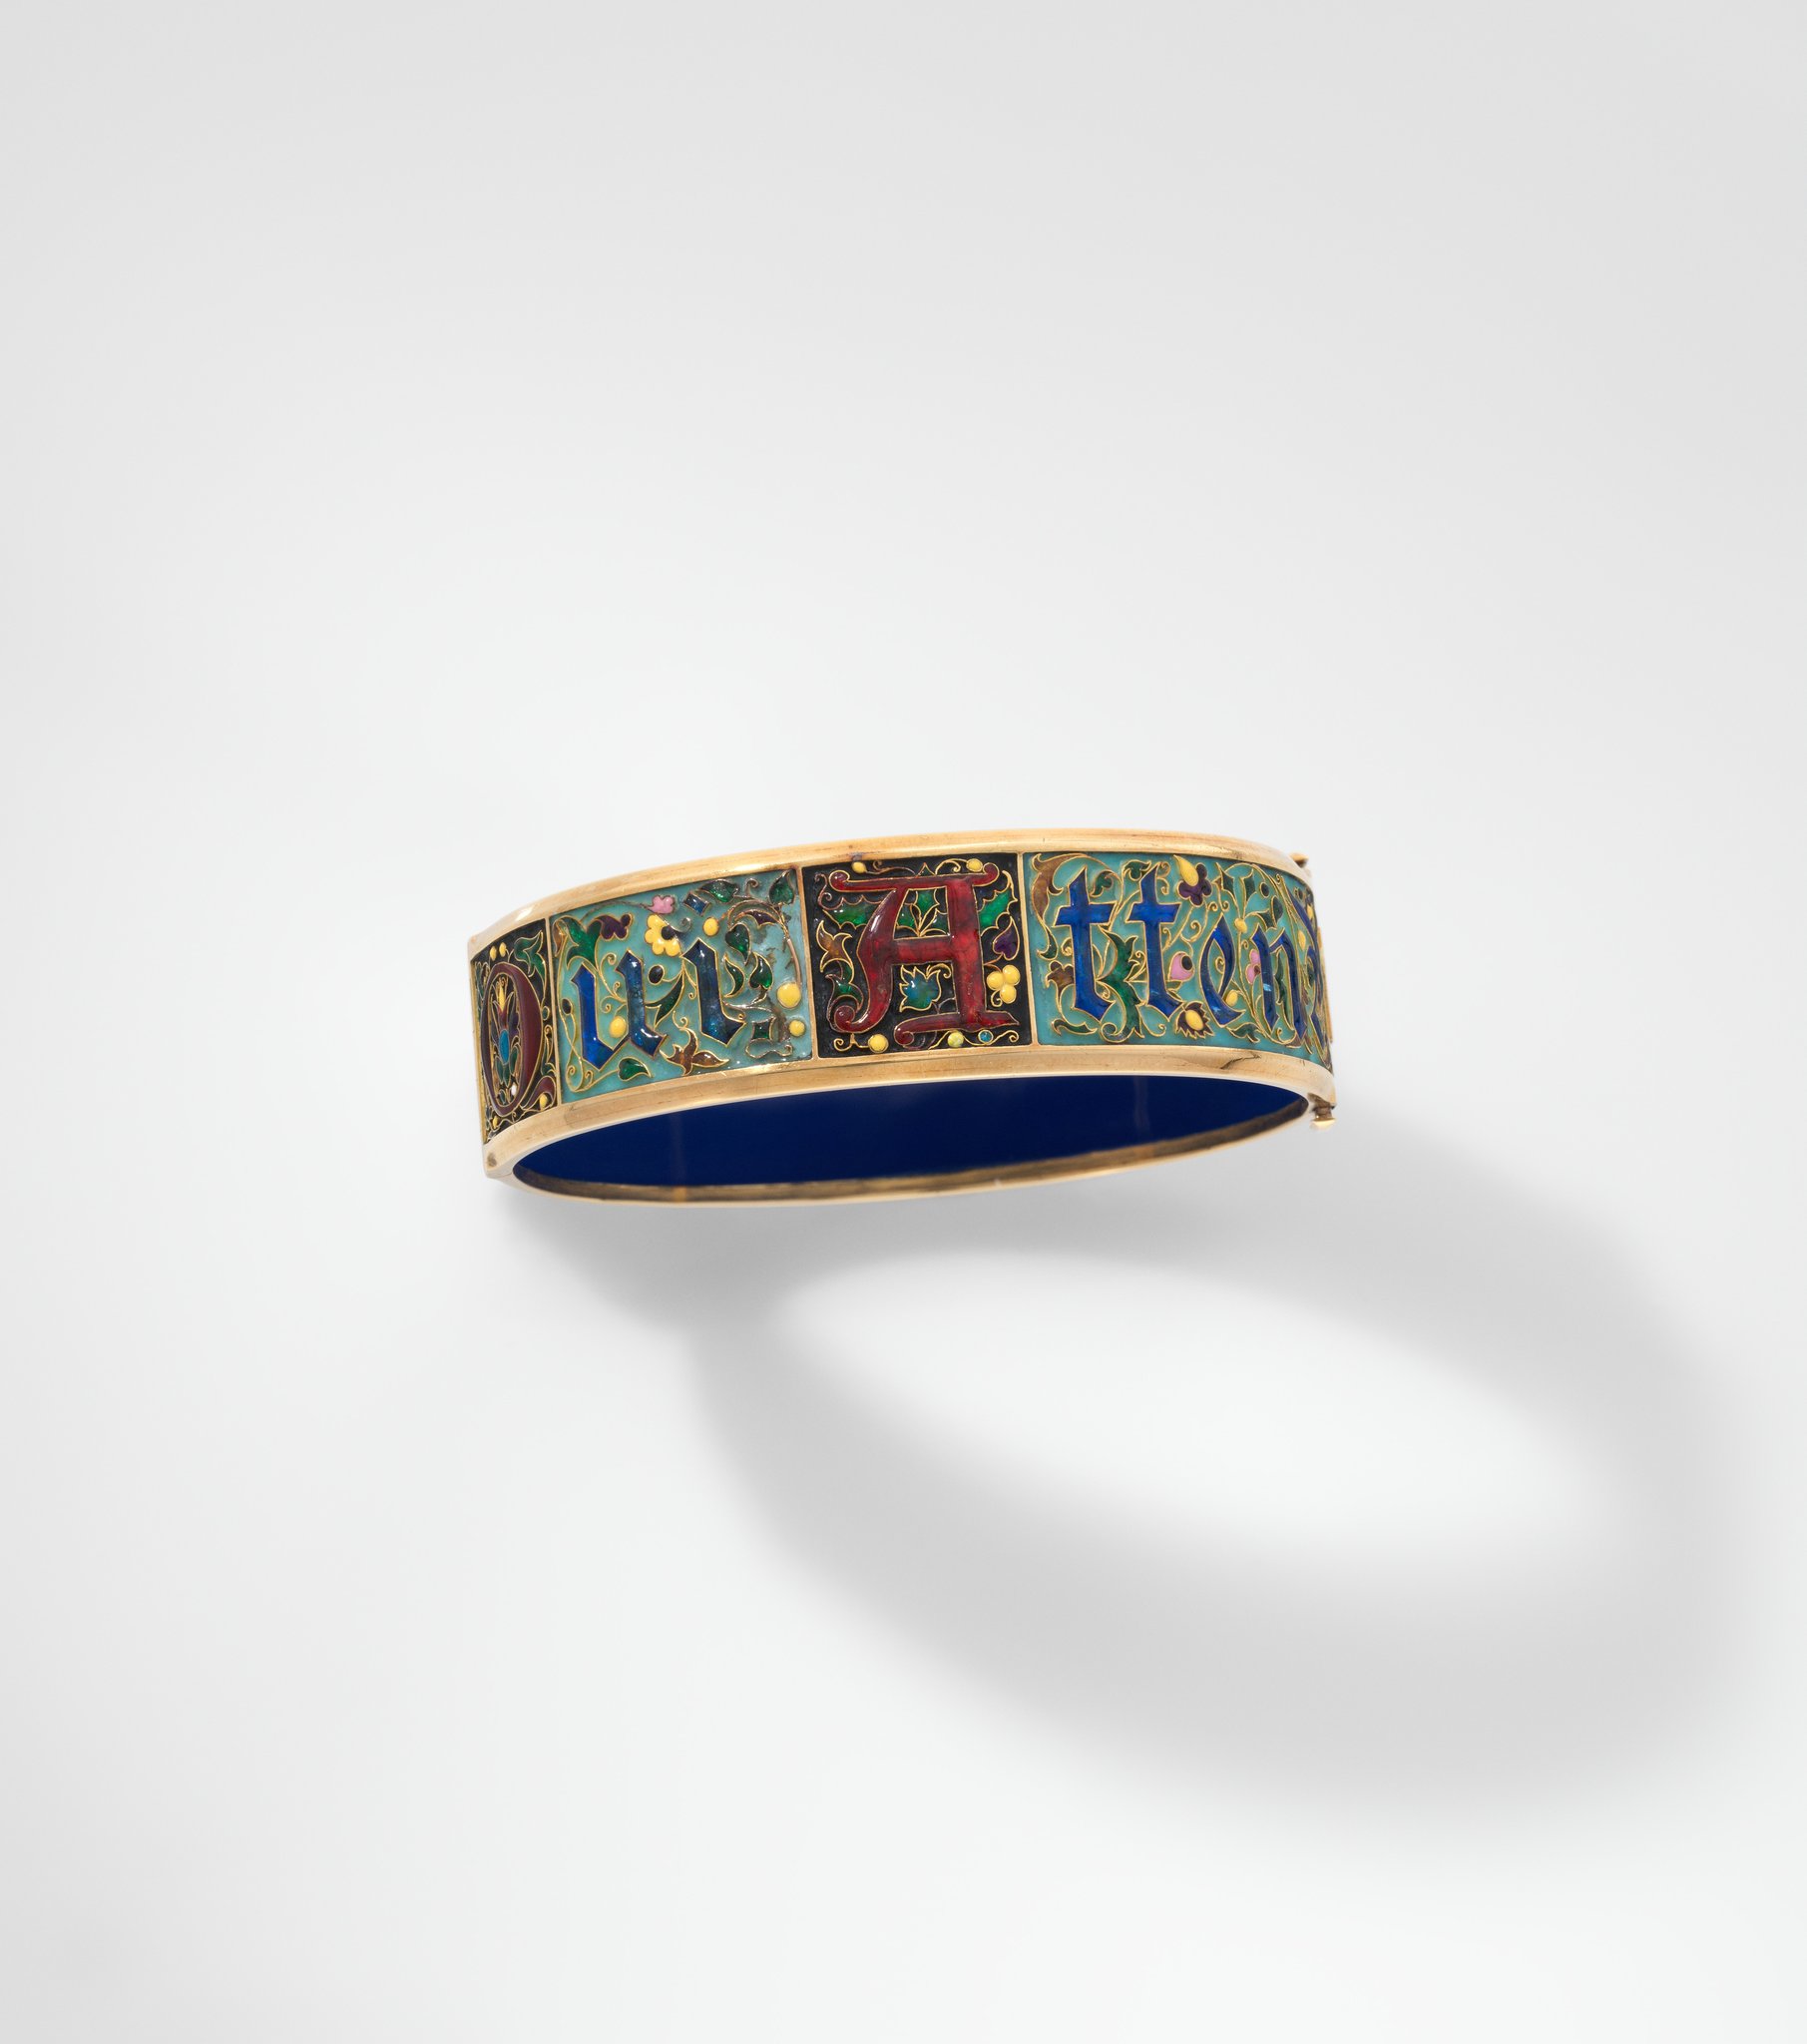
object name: bracelet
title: Bangle Bracelet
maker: alexis falize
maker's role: maker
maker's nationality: french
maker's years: 1811-1898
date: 1875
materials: enamel, gold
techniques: enamel